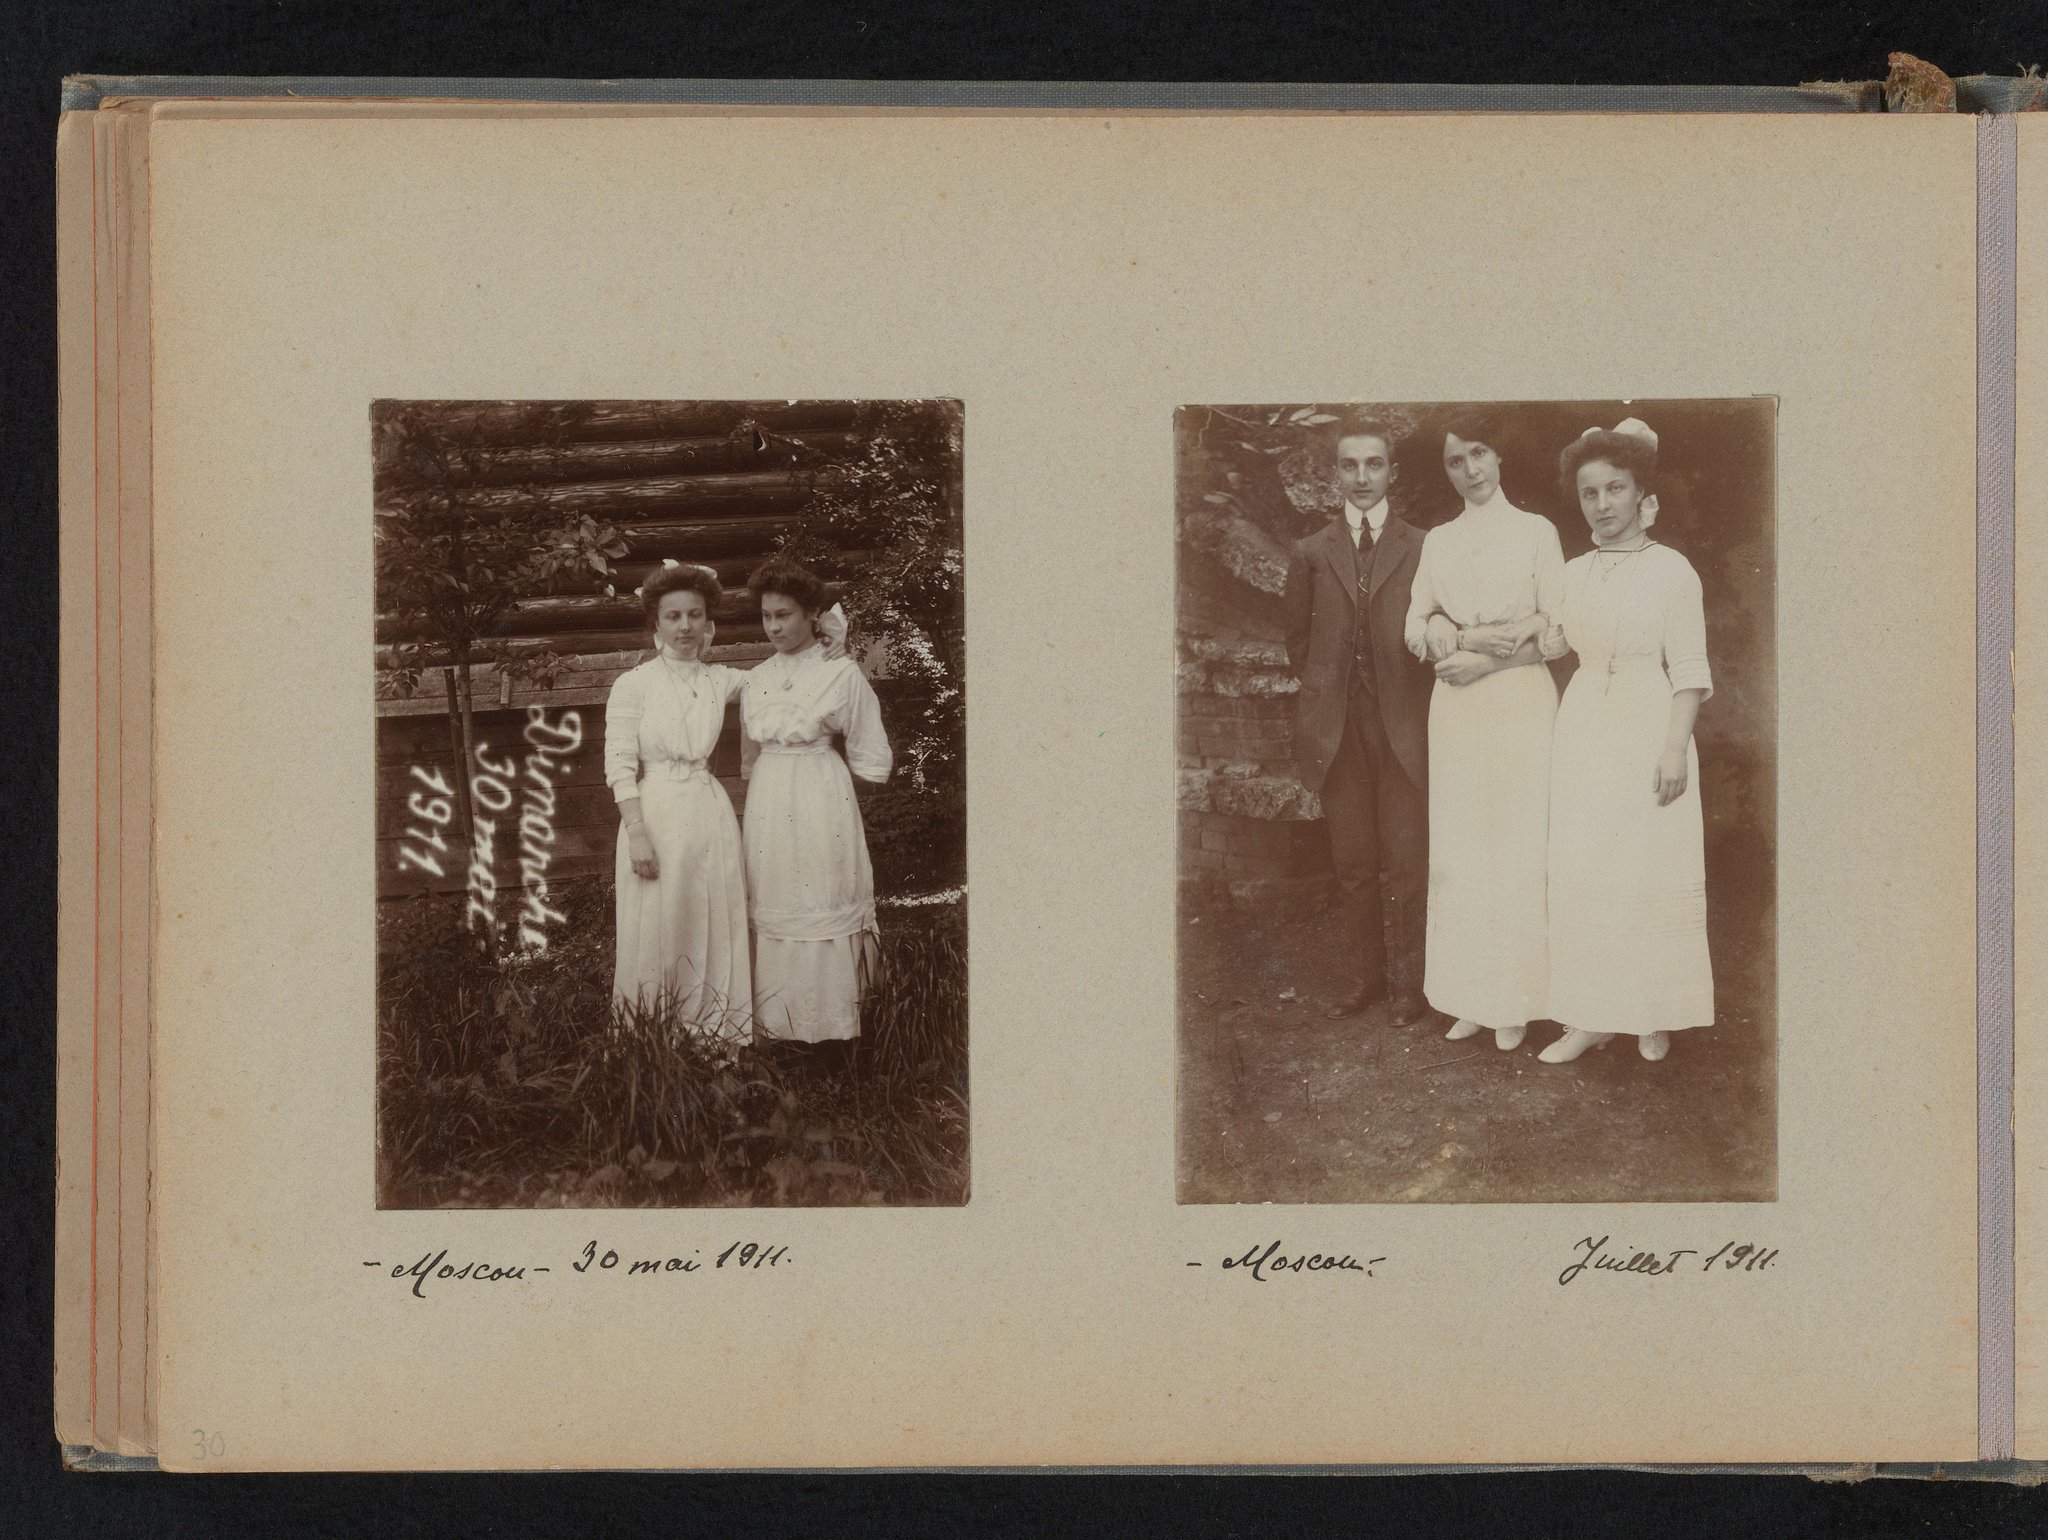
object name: album leaf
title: Portret van twee vrouwen en portret van een jongeman en twee vrouwen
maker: Anonymous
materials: paper, cardboard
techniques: collodion silver print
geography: moscow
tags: adolescent, young woman, maiden, historical persons, youth, adolescent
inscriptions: inscription: ‘- Moscou - 30 mai 1911.’, inscription: ‘- Moscou. - Juillet 1911.’, date: ‘Dimanche/ 30 mai/ 1911.’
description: Deze foto's maken deel uit van een album.